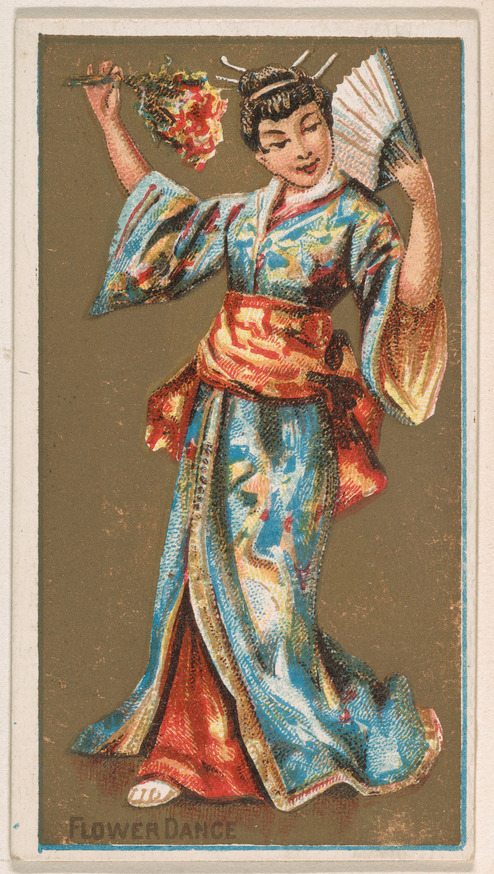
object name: print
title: Flower Dance, from National Dances (N225, Type 1) issued by Kinney Bros.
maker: kinney brothers tobacco company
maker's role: publisher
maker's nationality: american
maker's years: 1869-2011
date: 1889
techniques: color lithograph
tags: fans,women,dancers